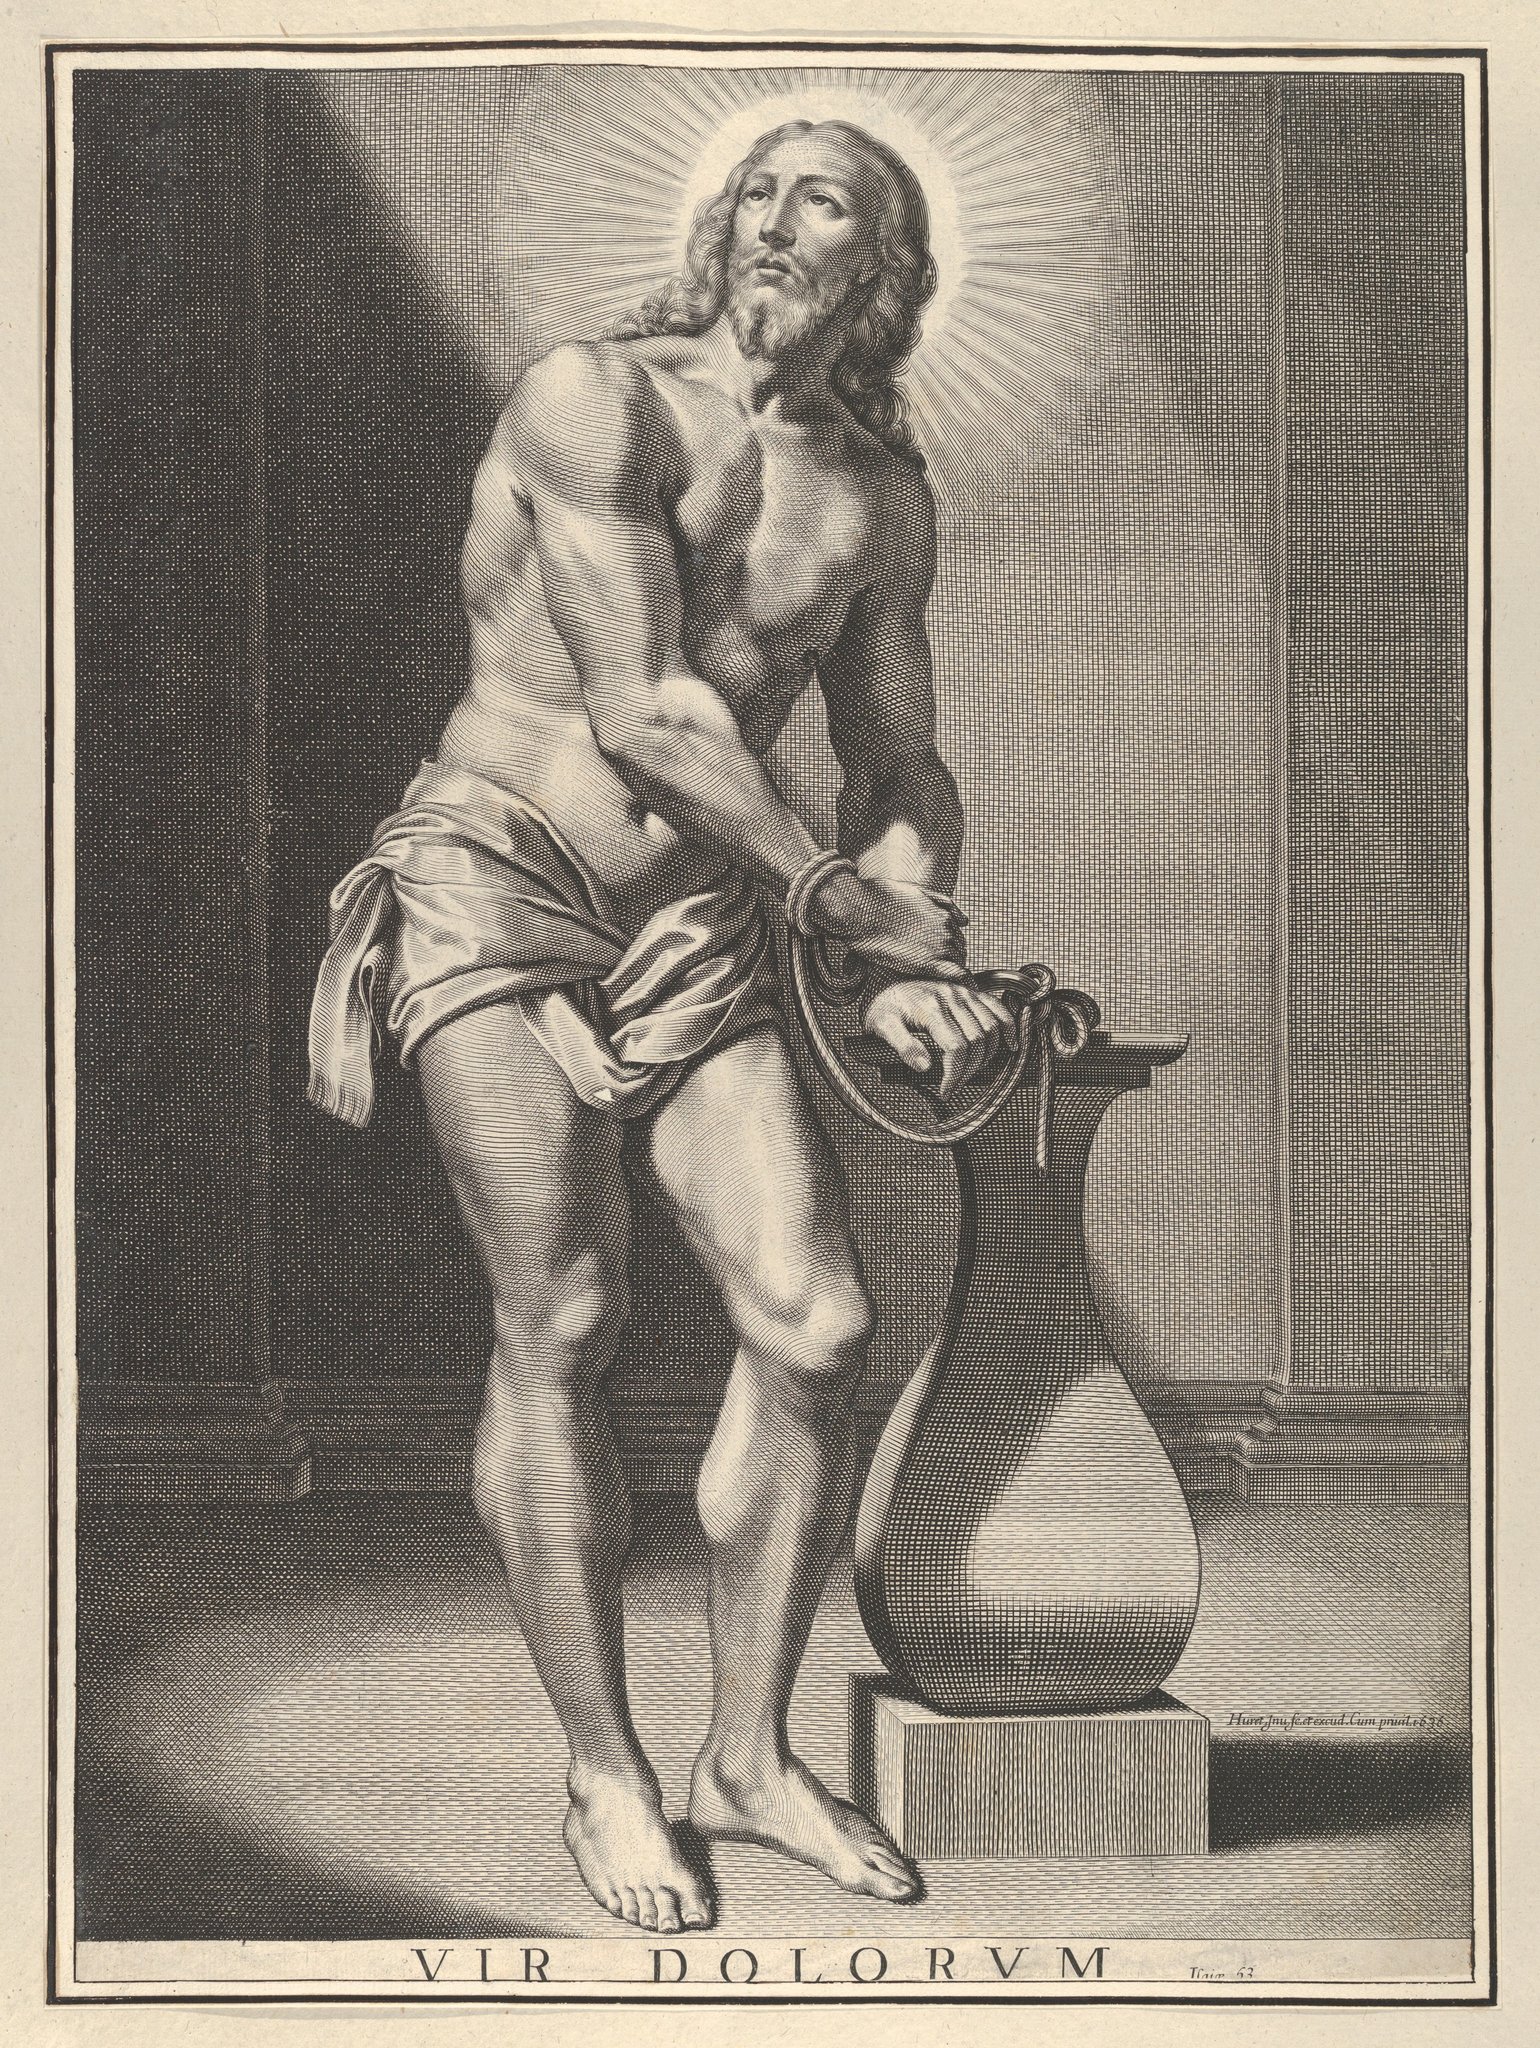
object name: print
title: Man of Sorrows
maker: grégoire huret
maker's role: artist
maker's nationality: french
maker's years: 1606-1670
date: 1636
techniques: engraving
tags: sadness,christ